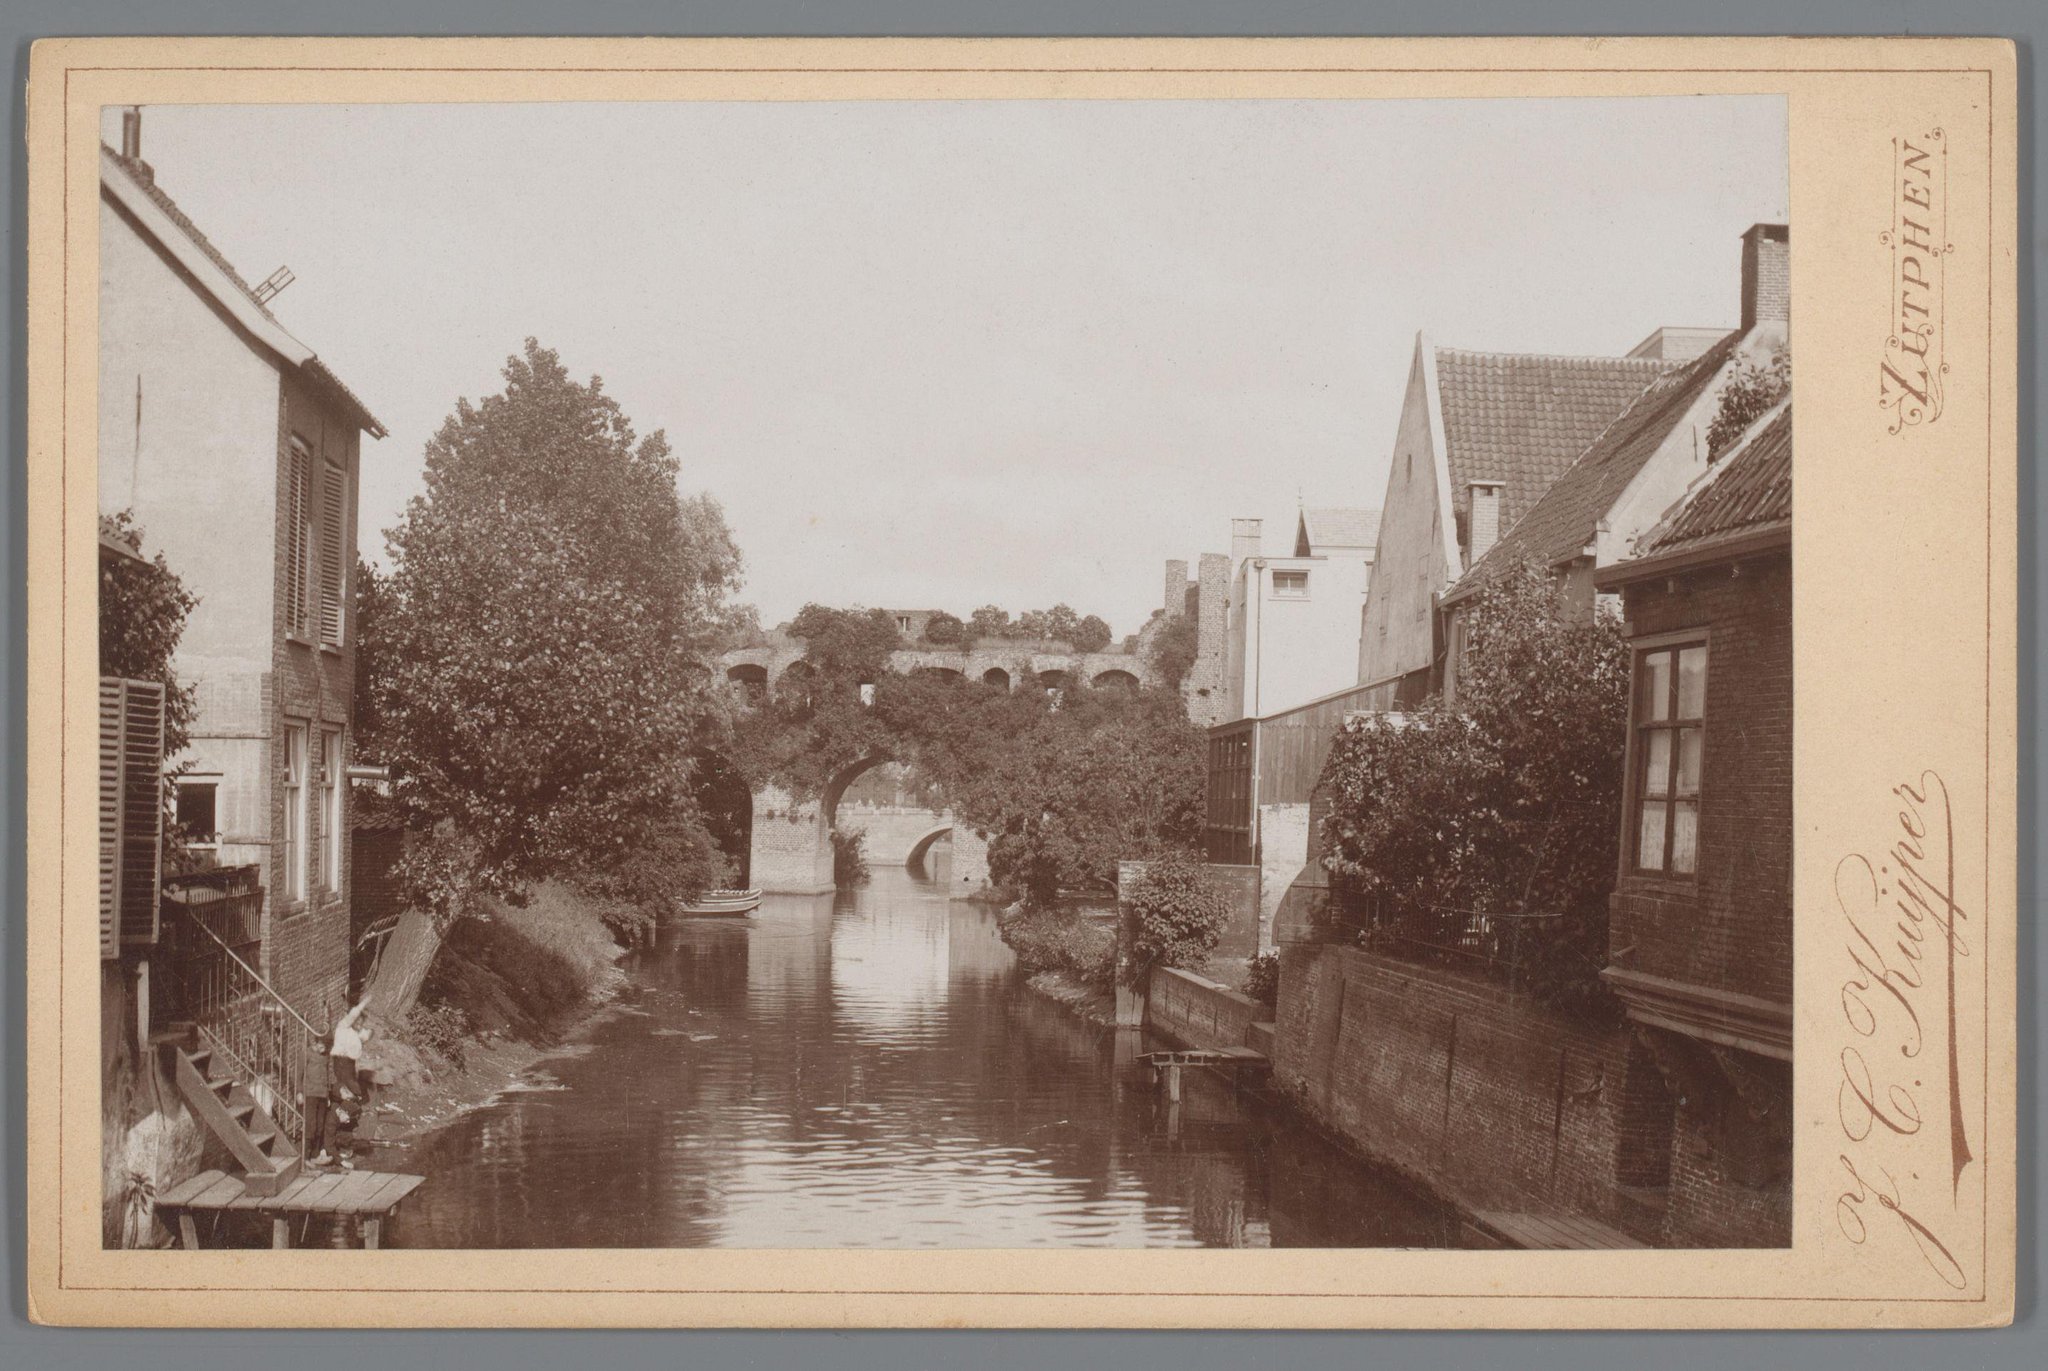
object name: photograph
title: Gezicht op de Berkelpoort te Zutphen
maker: jacobus cornelis kuijper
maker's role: fotograaf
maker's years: 1852-1924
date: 1880-1915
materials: cardboard, photographic support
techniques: collodion silver print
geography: zutphen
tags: watergate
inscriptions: inscription: ‘Photografie Instantanée/ J.C. Kuijper/ Zutphen/ Boompjeswal en Bornhovestraat E.141’